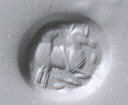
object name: stamp seal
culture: sasanian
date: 401-700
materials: stone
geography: iran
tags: animals